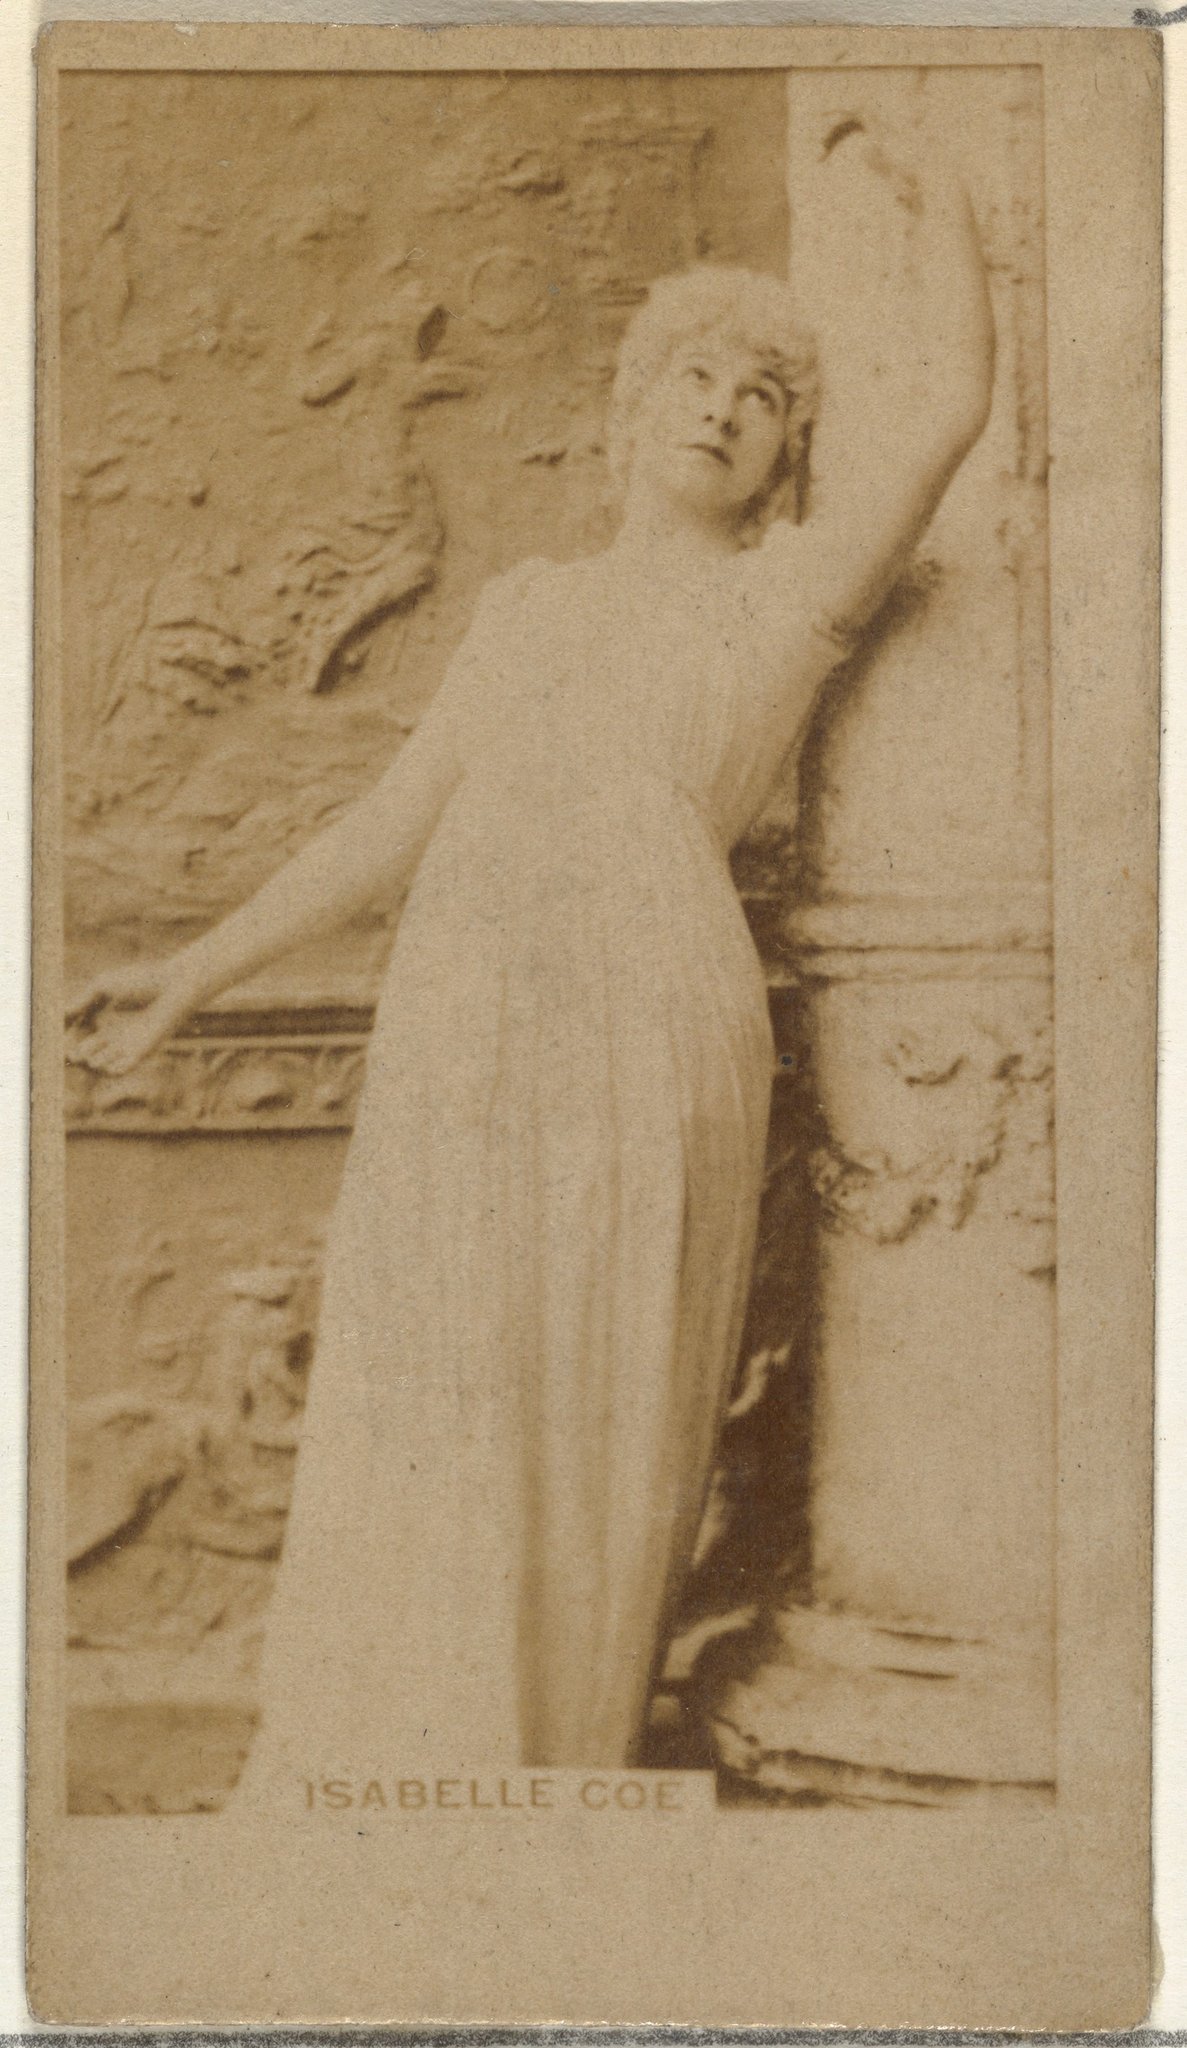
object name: photograph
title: Isabelle Coe, from the Actors and Actresses series (N145-8) issued by Duke Sons & Co. to promote Duke Cigarettes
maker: w. duke, sons & co.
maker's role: publisher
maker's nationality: american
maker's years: 1870-1920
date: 1891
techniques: albumen silver print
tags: portraits,women,actresses